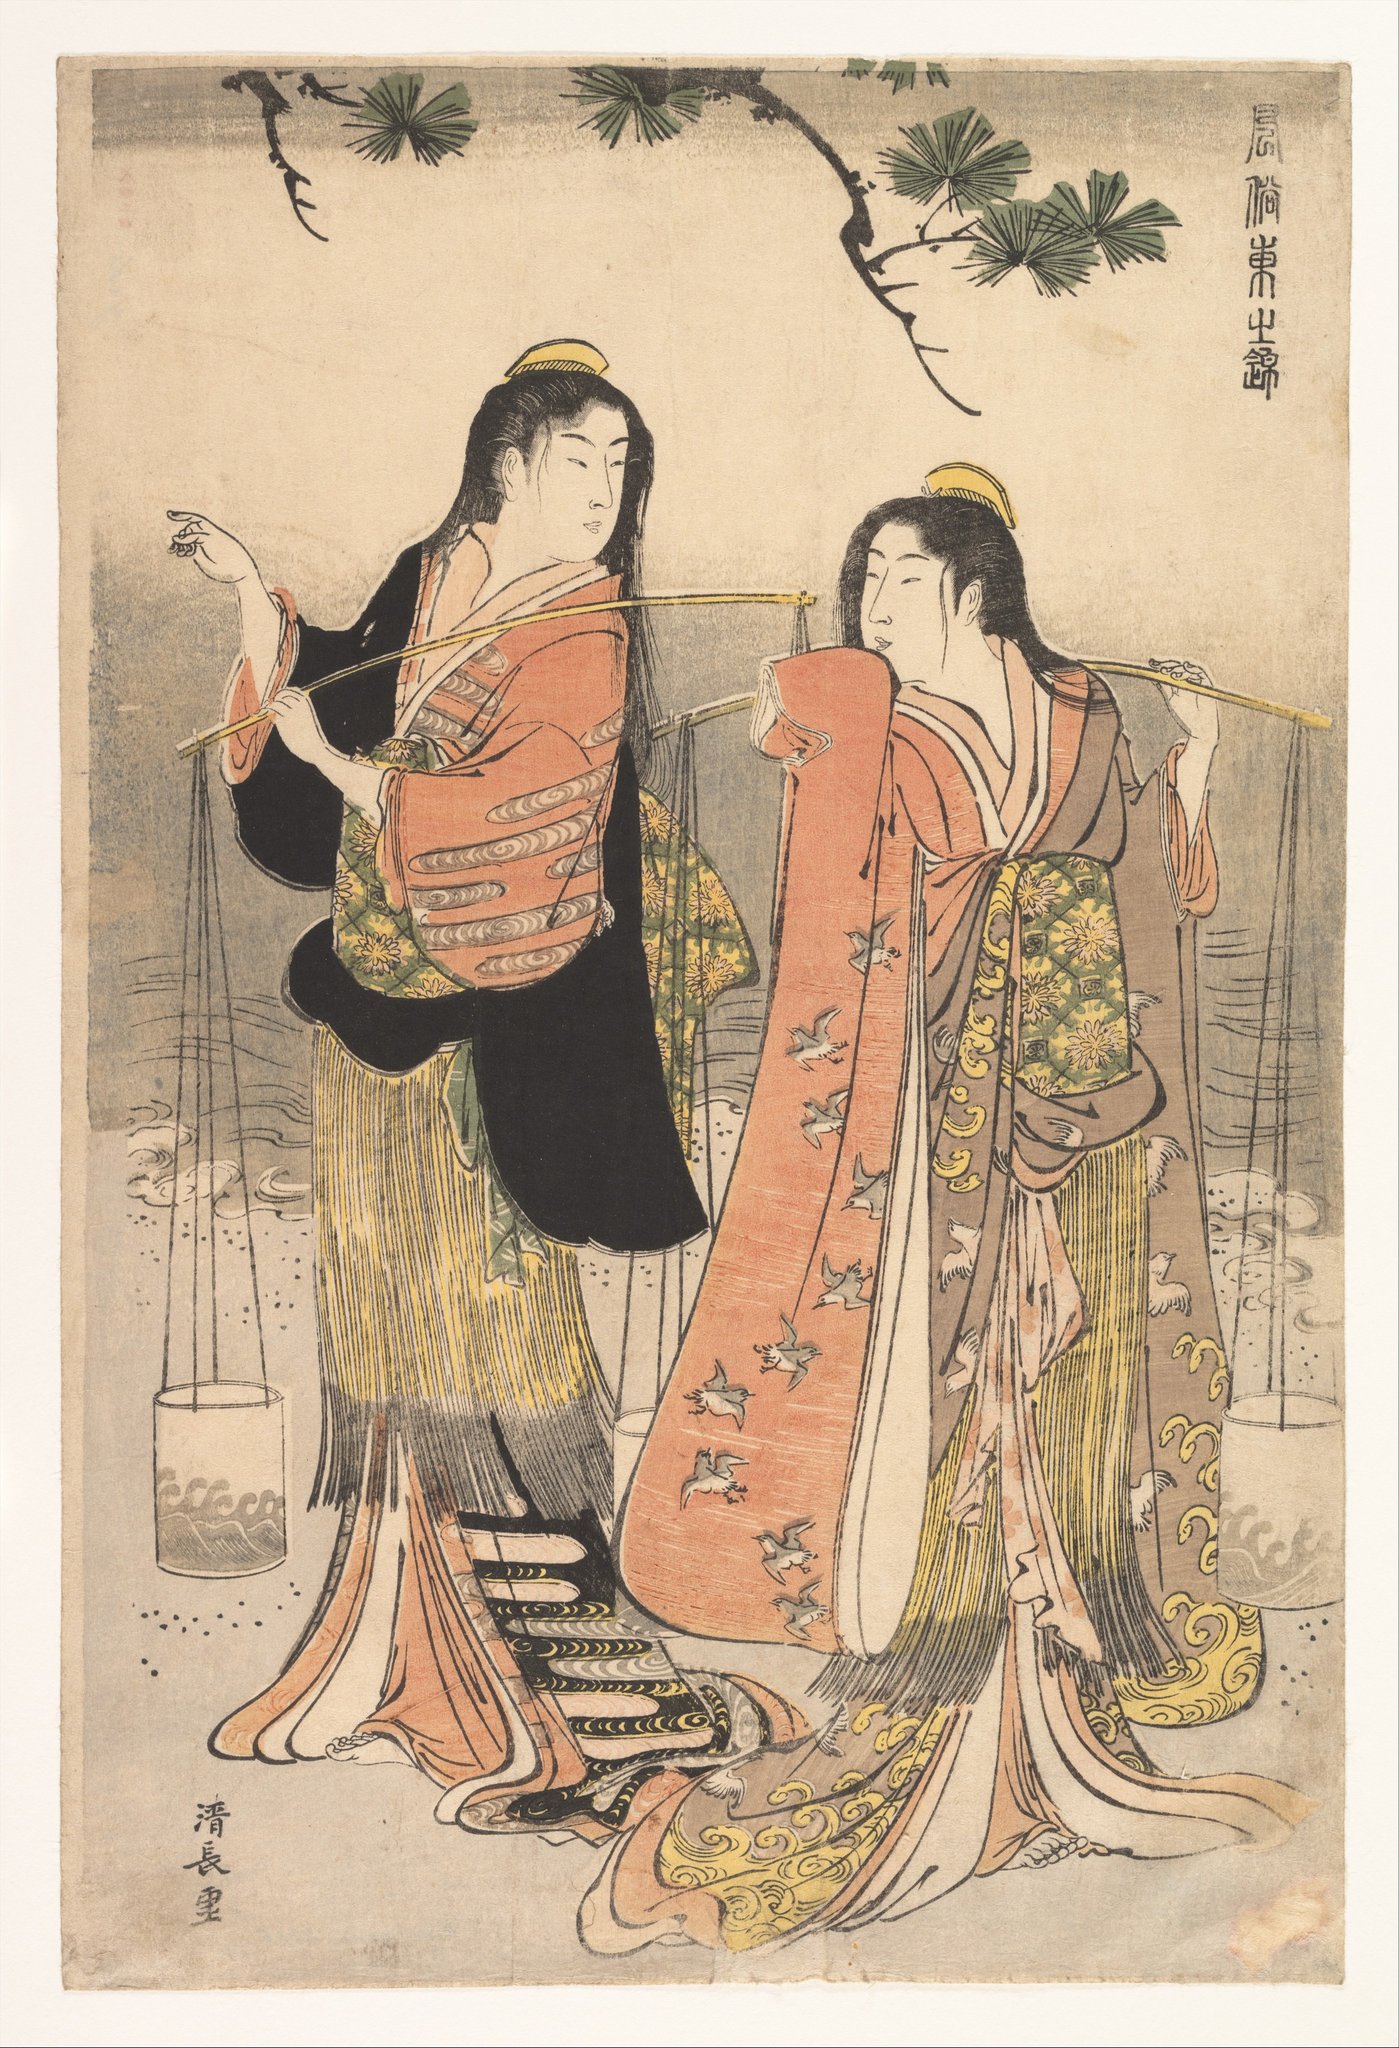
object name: print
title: The Brine Maidens of Suma (Shiokumi, Suma)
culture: japanese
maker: torii kiyonaga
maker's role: artist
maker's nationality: japanese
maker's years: 1752-1815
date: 1783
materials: ink, paper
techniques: woodblock print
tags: women